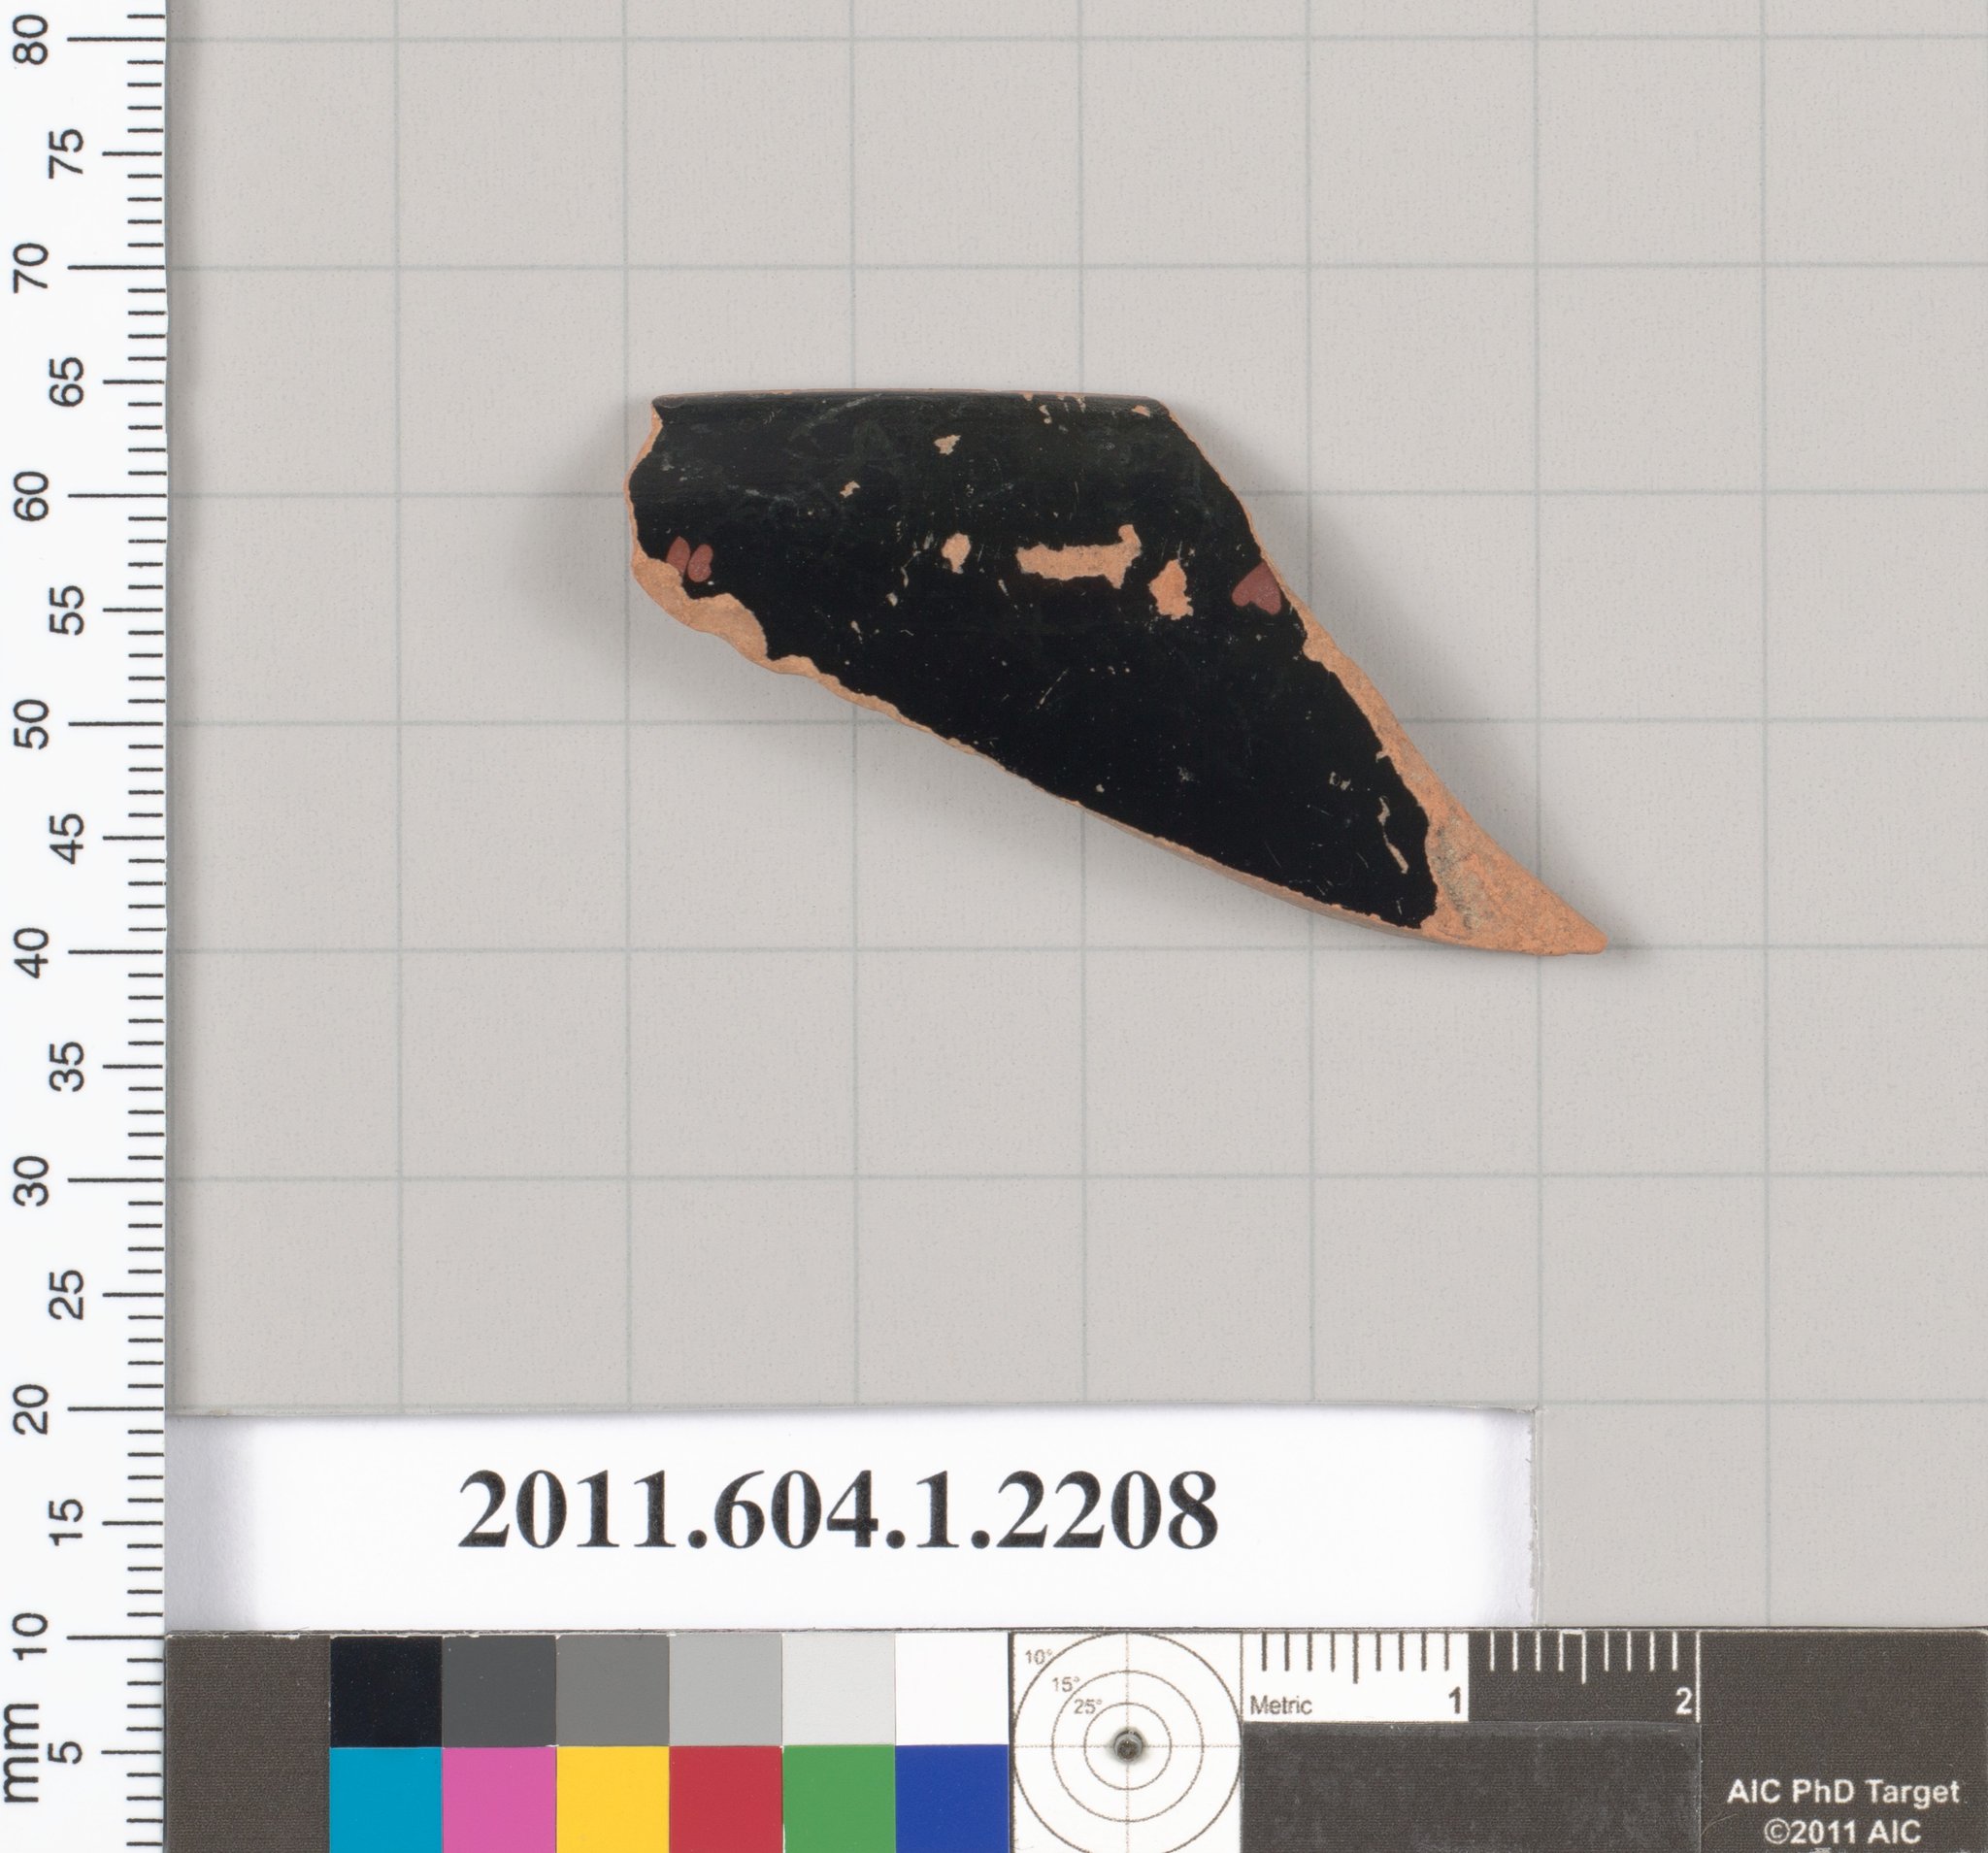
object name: kylix fragment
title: Terracotta rim fragment of a kylix (drinking cup)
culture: greek, attic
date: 500-451 BCE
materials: terracotta